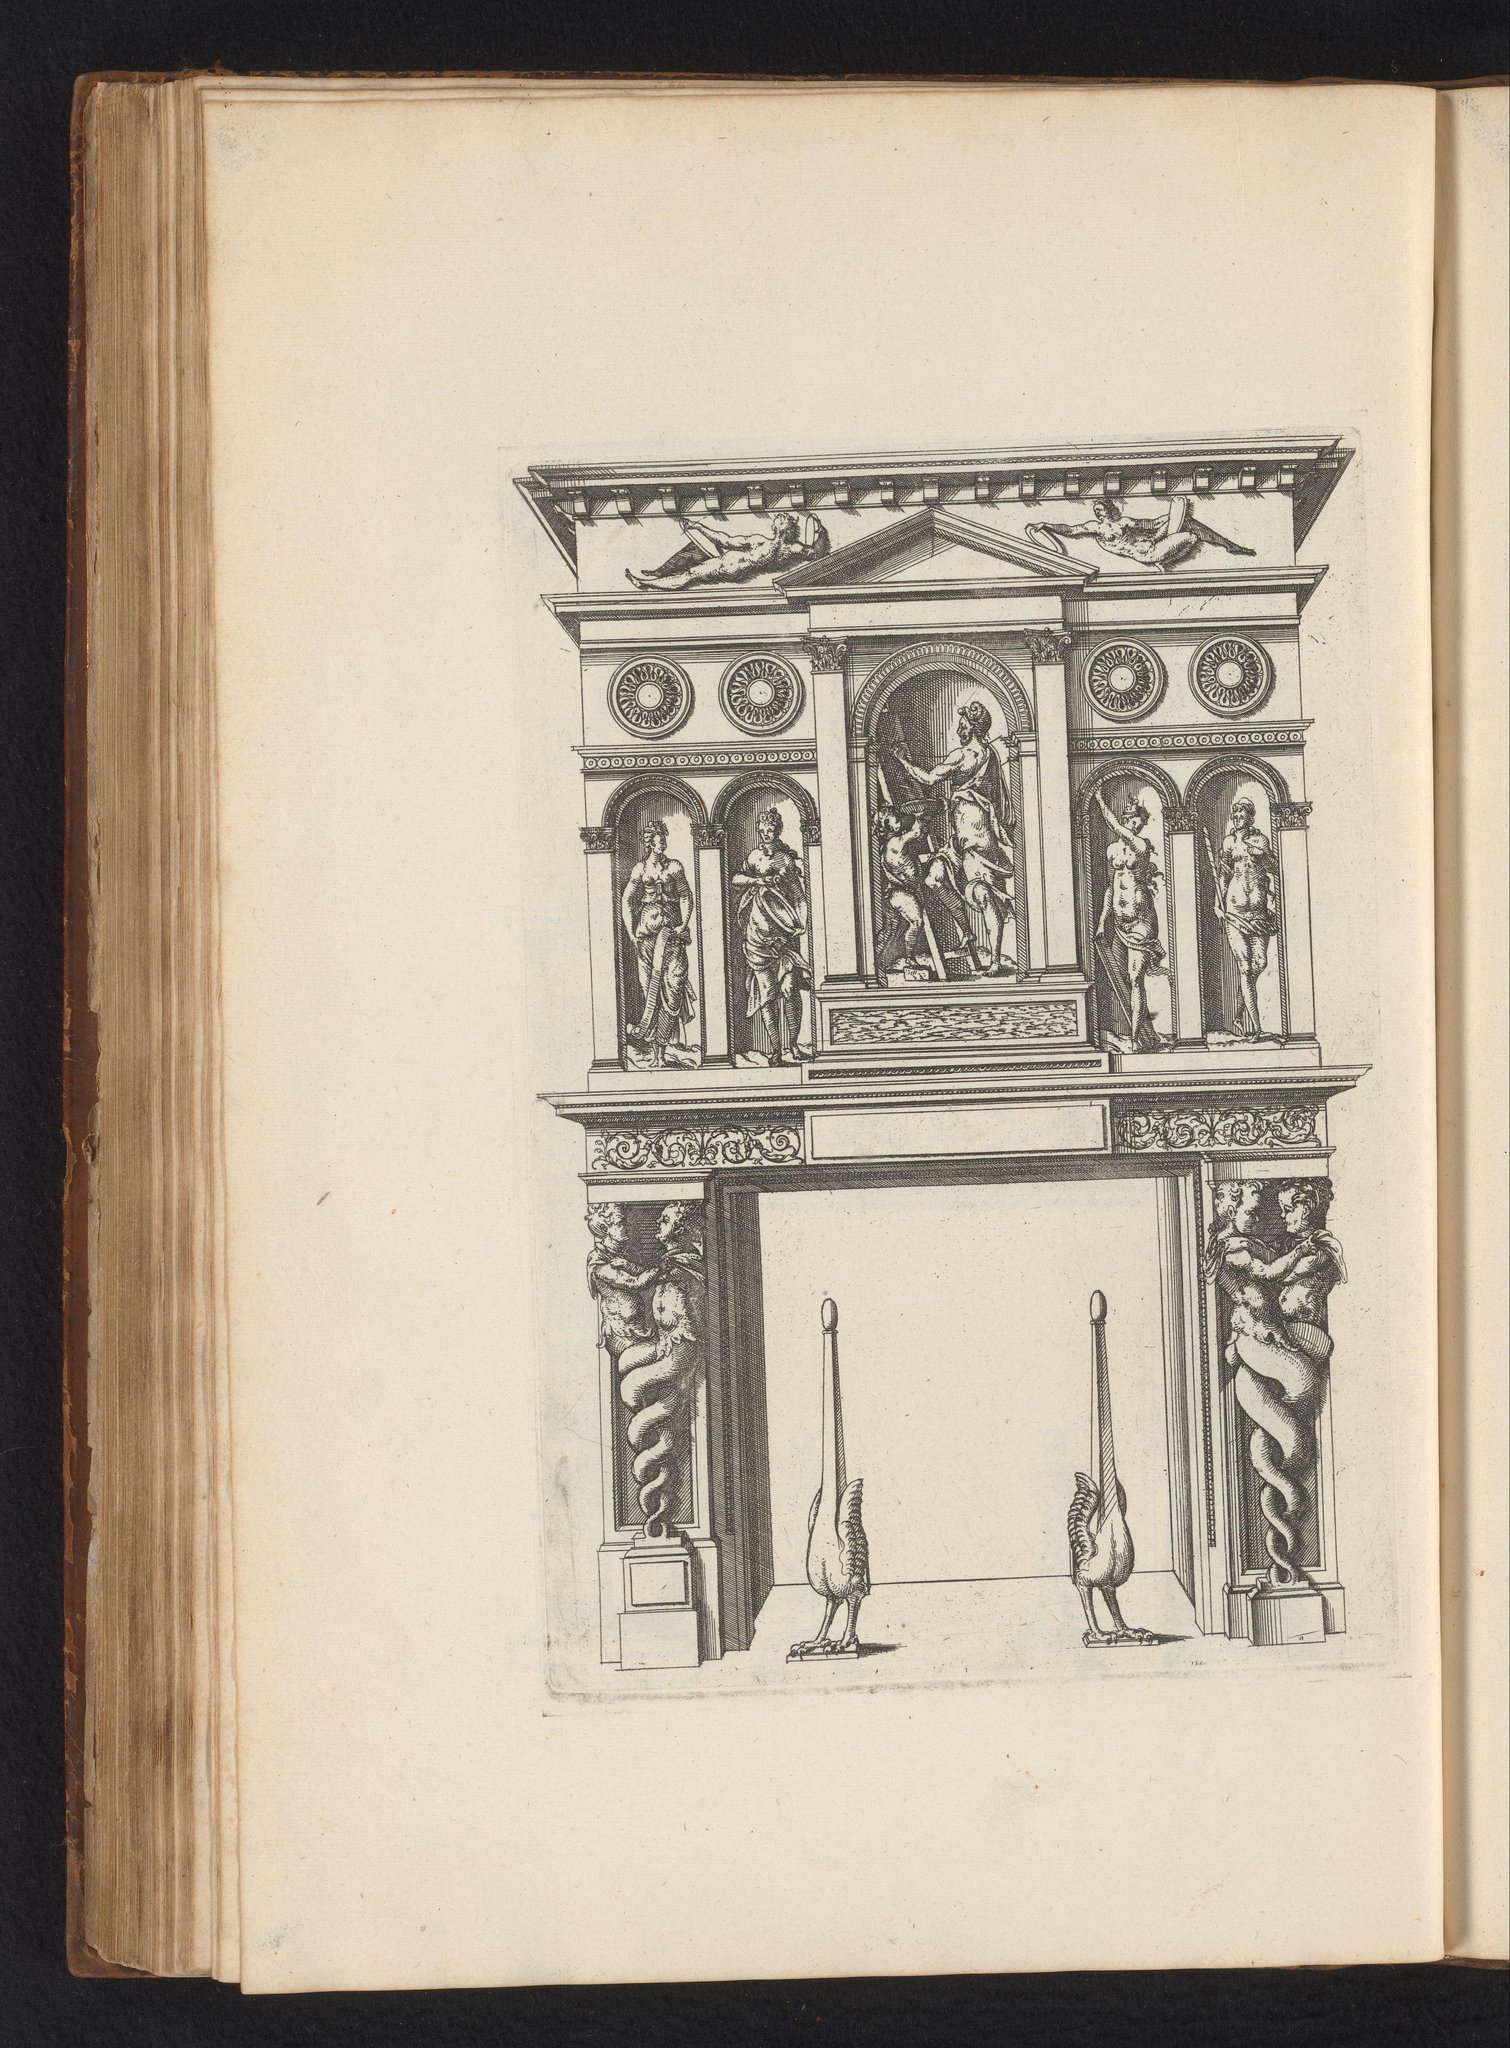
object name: ornament print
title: Schoorsteenmantel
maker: jacques androuet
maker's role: draughtsman, print maker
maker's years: 1515-1584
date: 1561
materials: paper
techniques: etching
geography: paris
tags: piece of sculpture, reproduction of a piece of sculpture, architectural design or model, chimney-piece, mantelpiece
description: Schoorsteenmantel met op de schouw standbeelden in nissen. Onderdeel van 'Seconde livre d'architectvre' (1561): 64 etsen met geornamenteerde architectuuronderdelen.